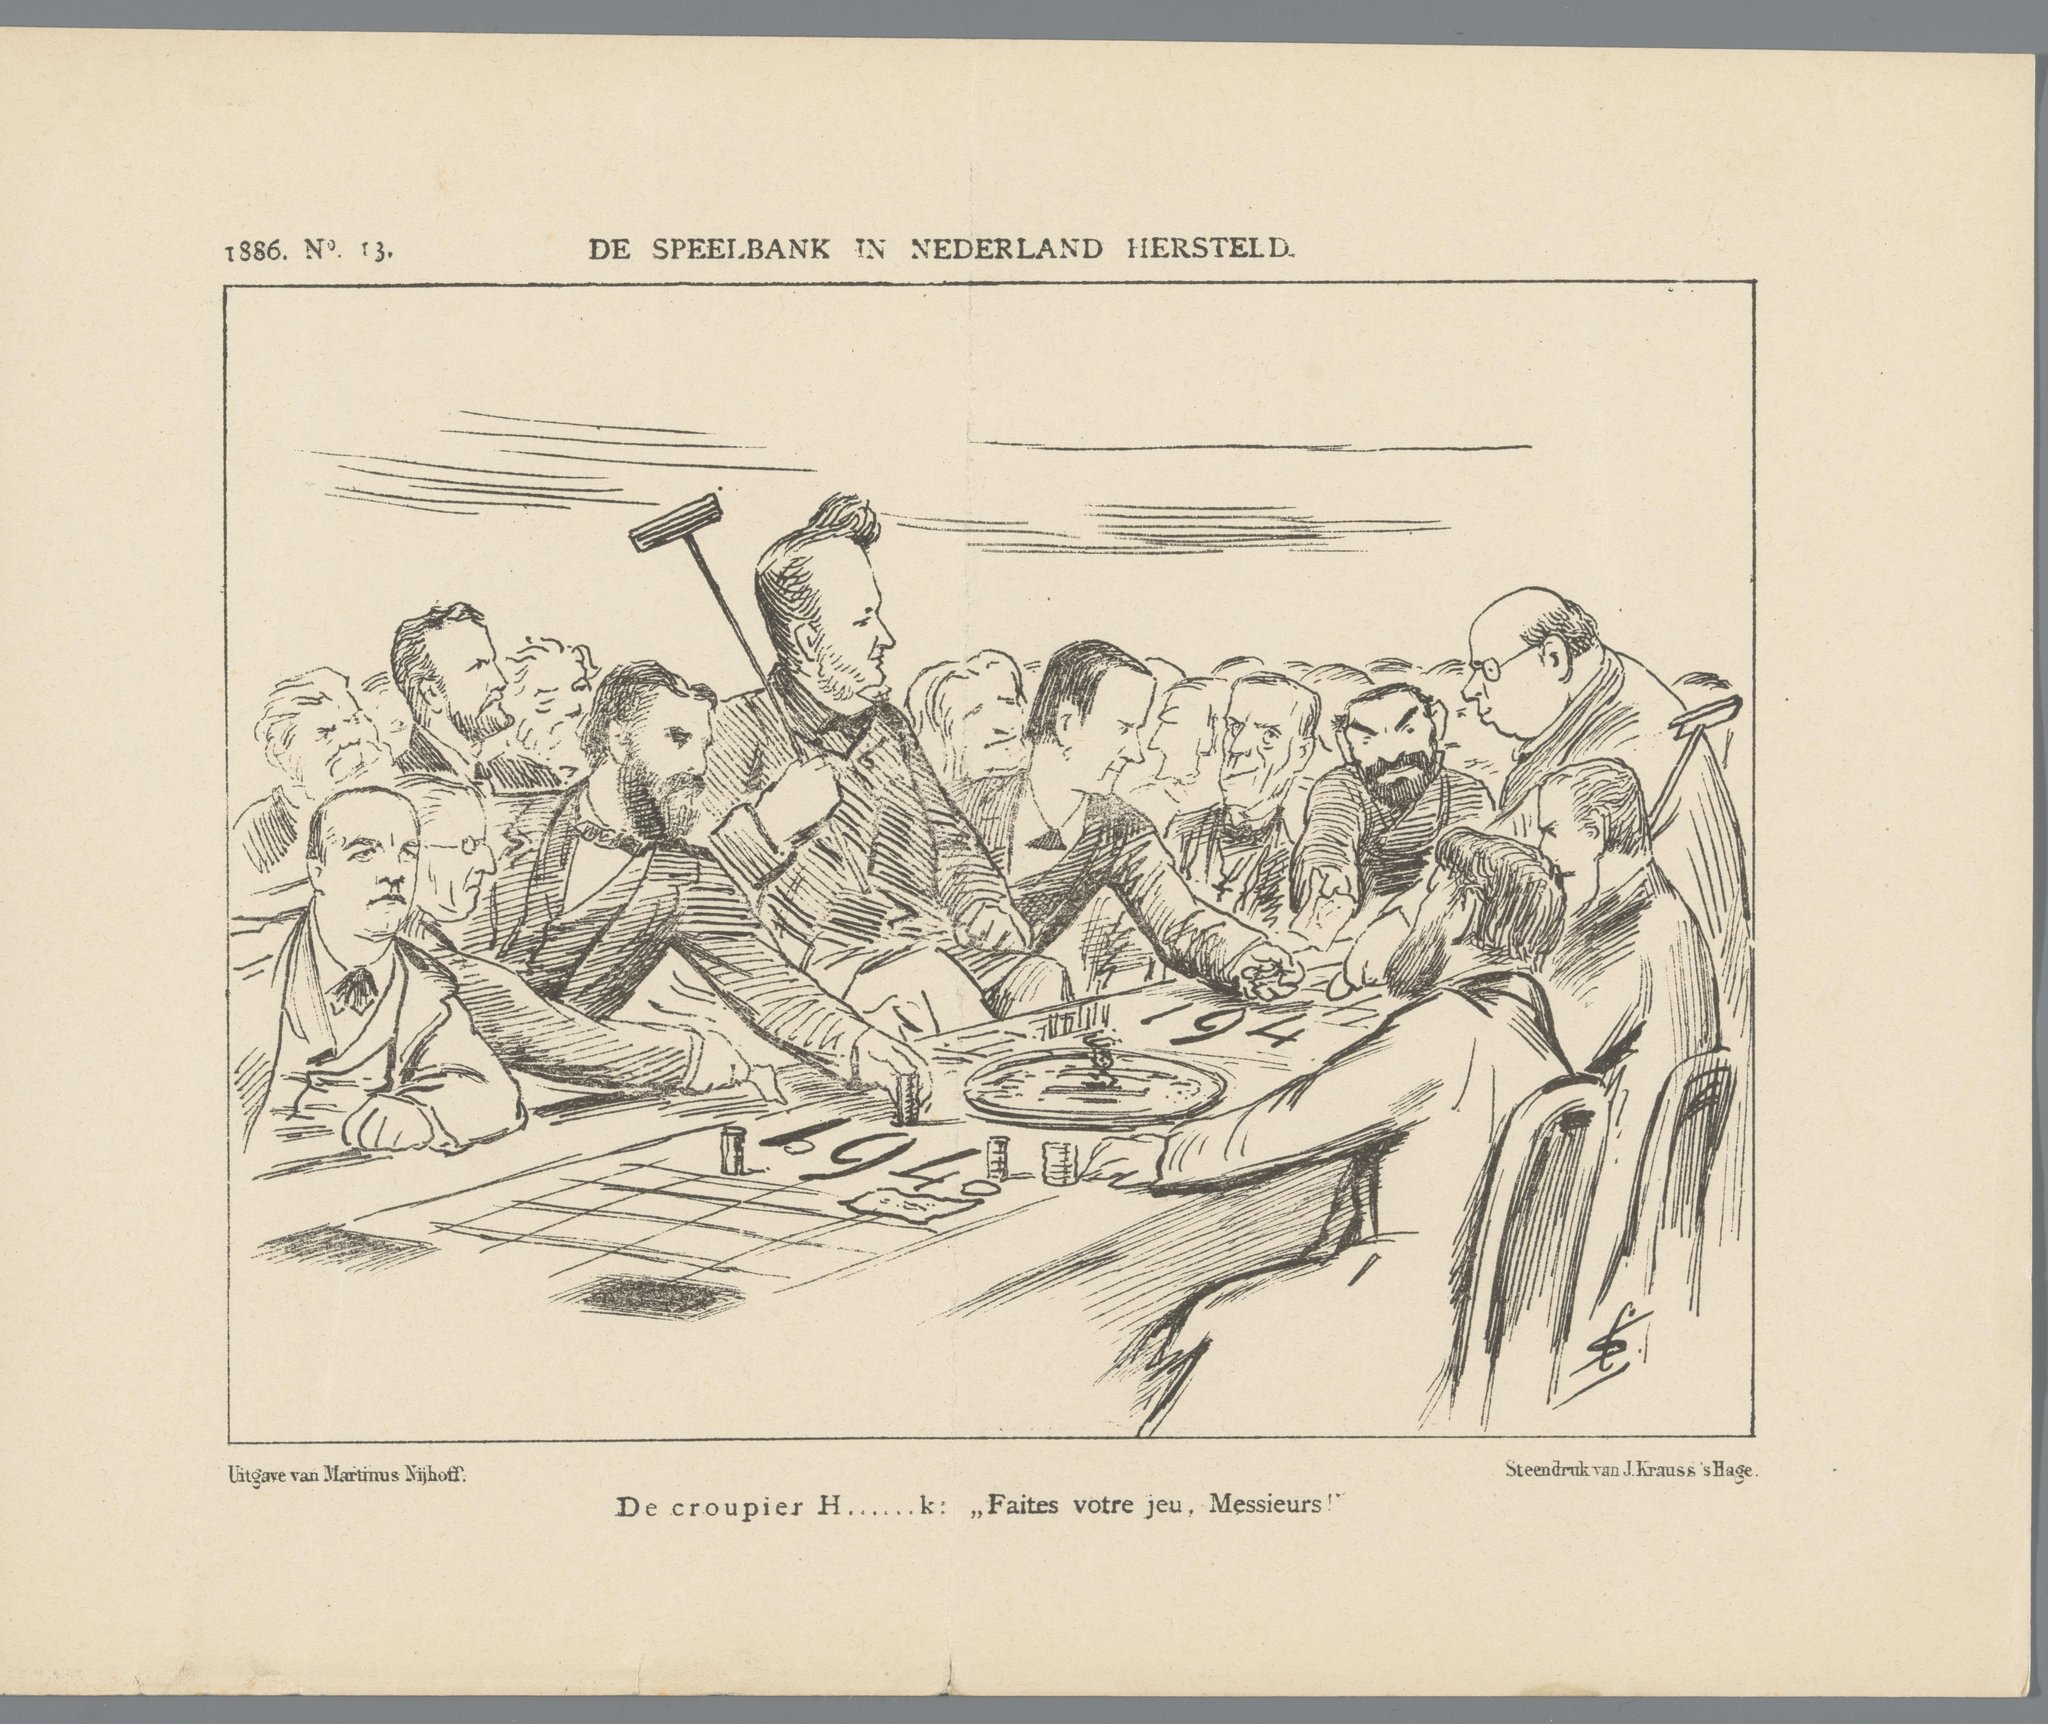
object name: cartoon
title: Spotprent met Heemskerk als croupier, 1886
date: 1886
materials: paper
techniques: lithograph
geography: netherlands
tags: amsterdam, the hague, politician, roulette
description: Spotprent met Heemskerk als croupier aan de roulettetafel over artikel 194. Plaat verschenen bij het weekblad De Nederlandsche Spectator, nr. 13, 1886.